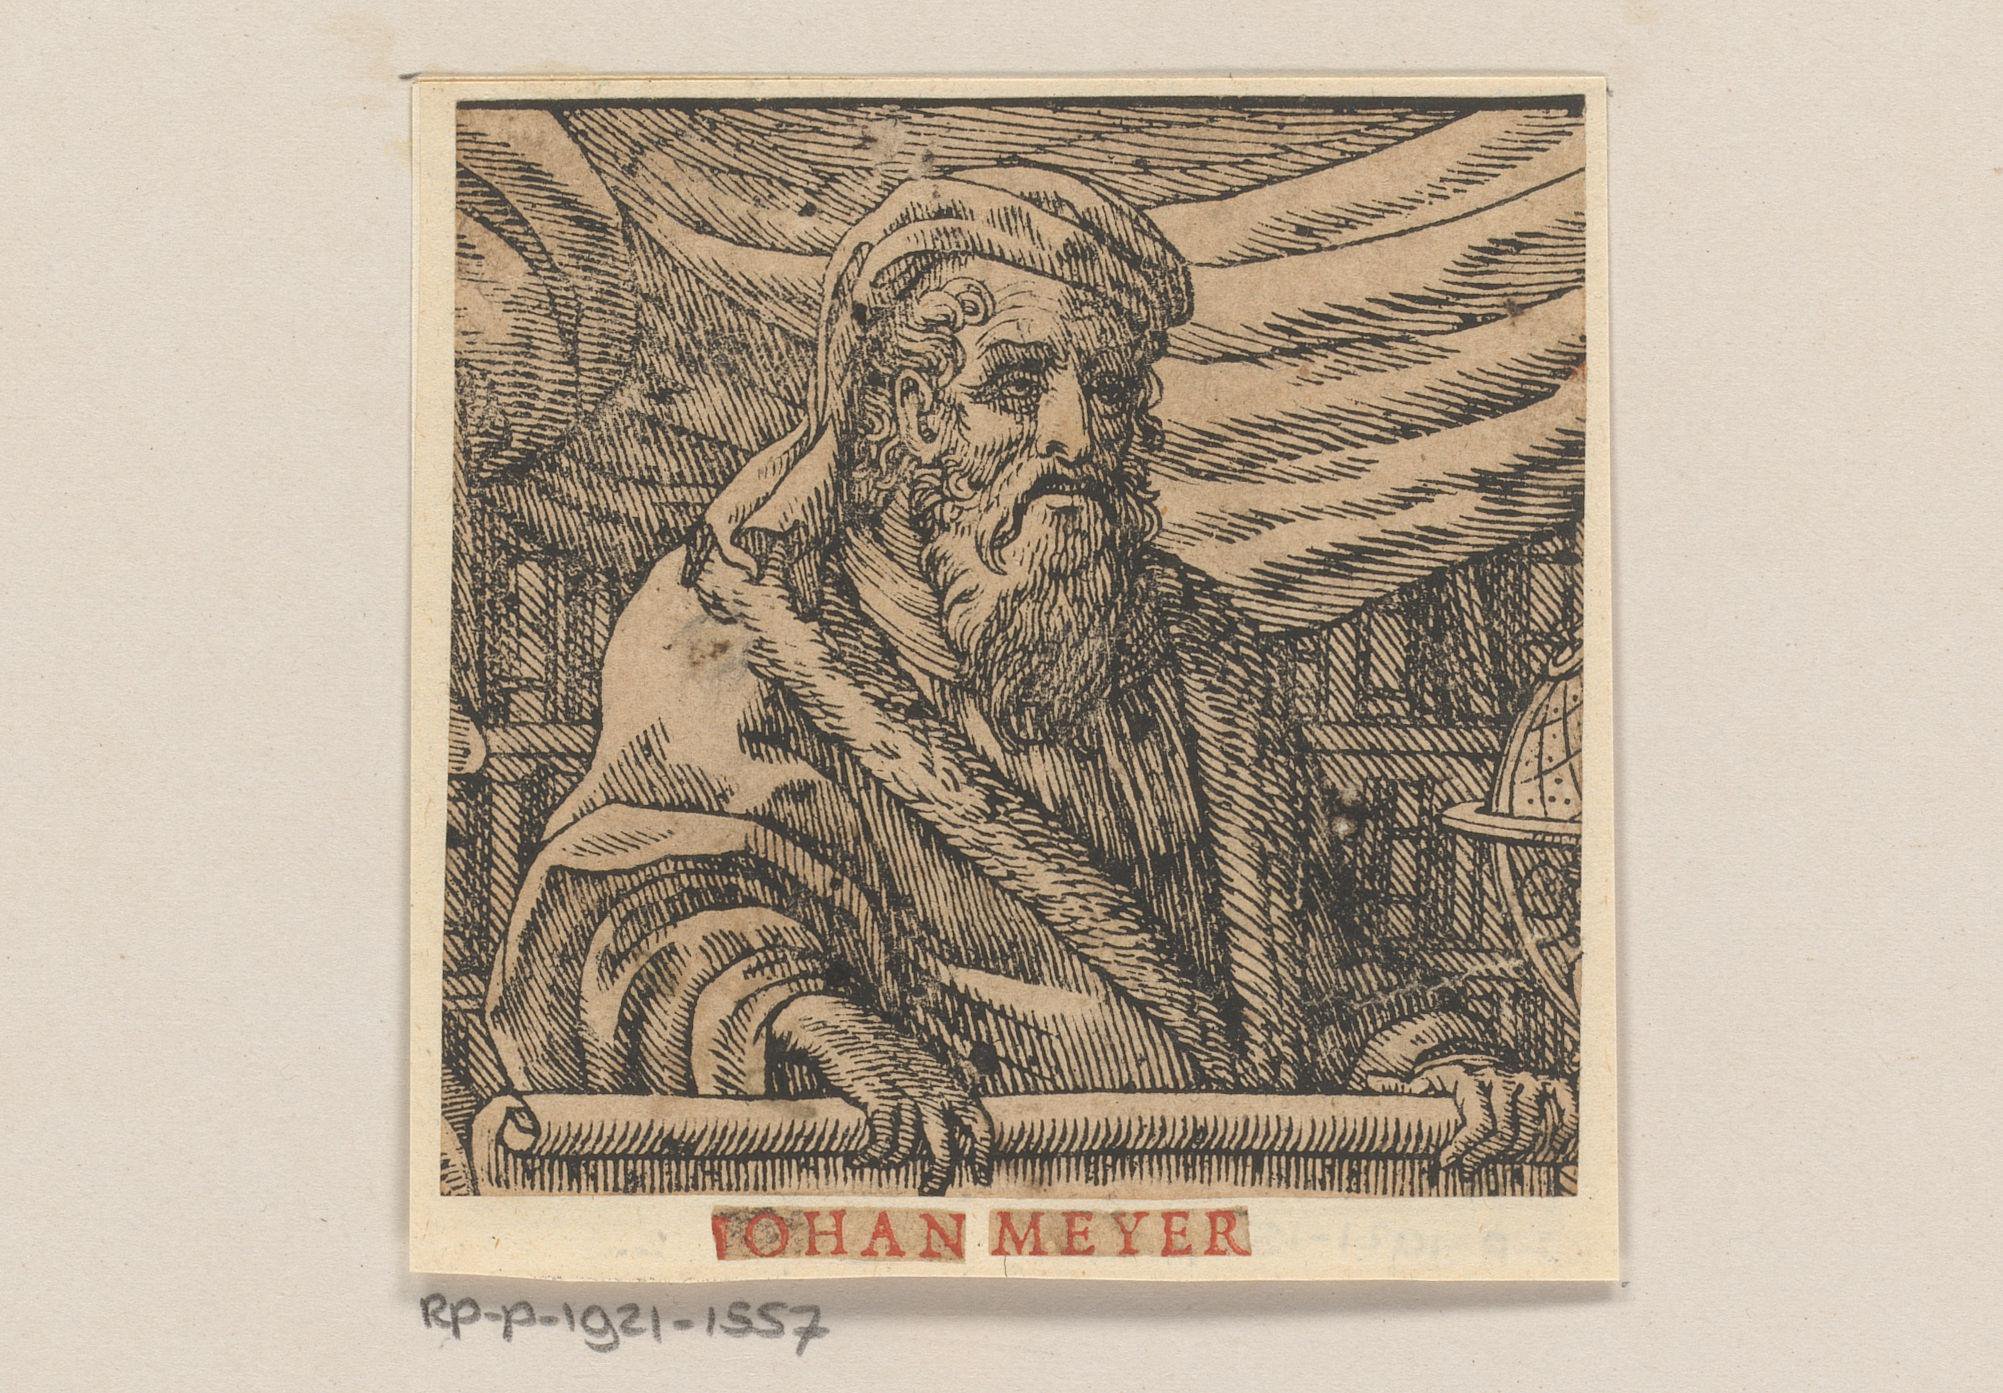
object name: print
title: Johan Meyer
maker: Anonymous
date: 1500-1650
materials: paper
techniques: snipping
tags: historical persons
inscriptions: collector's mark: Lugt 2233